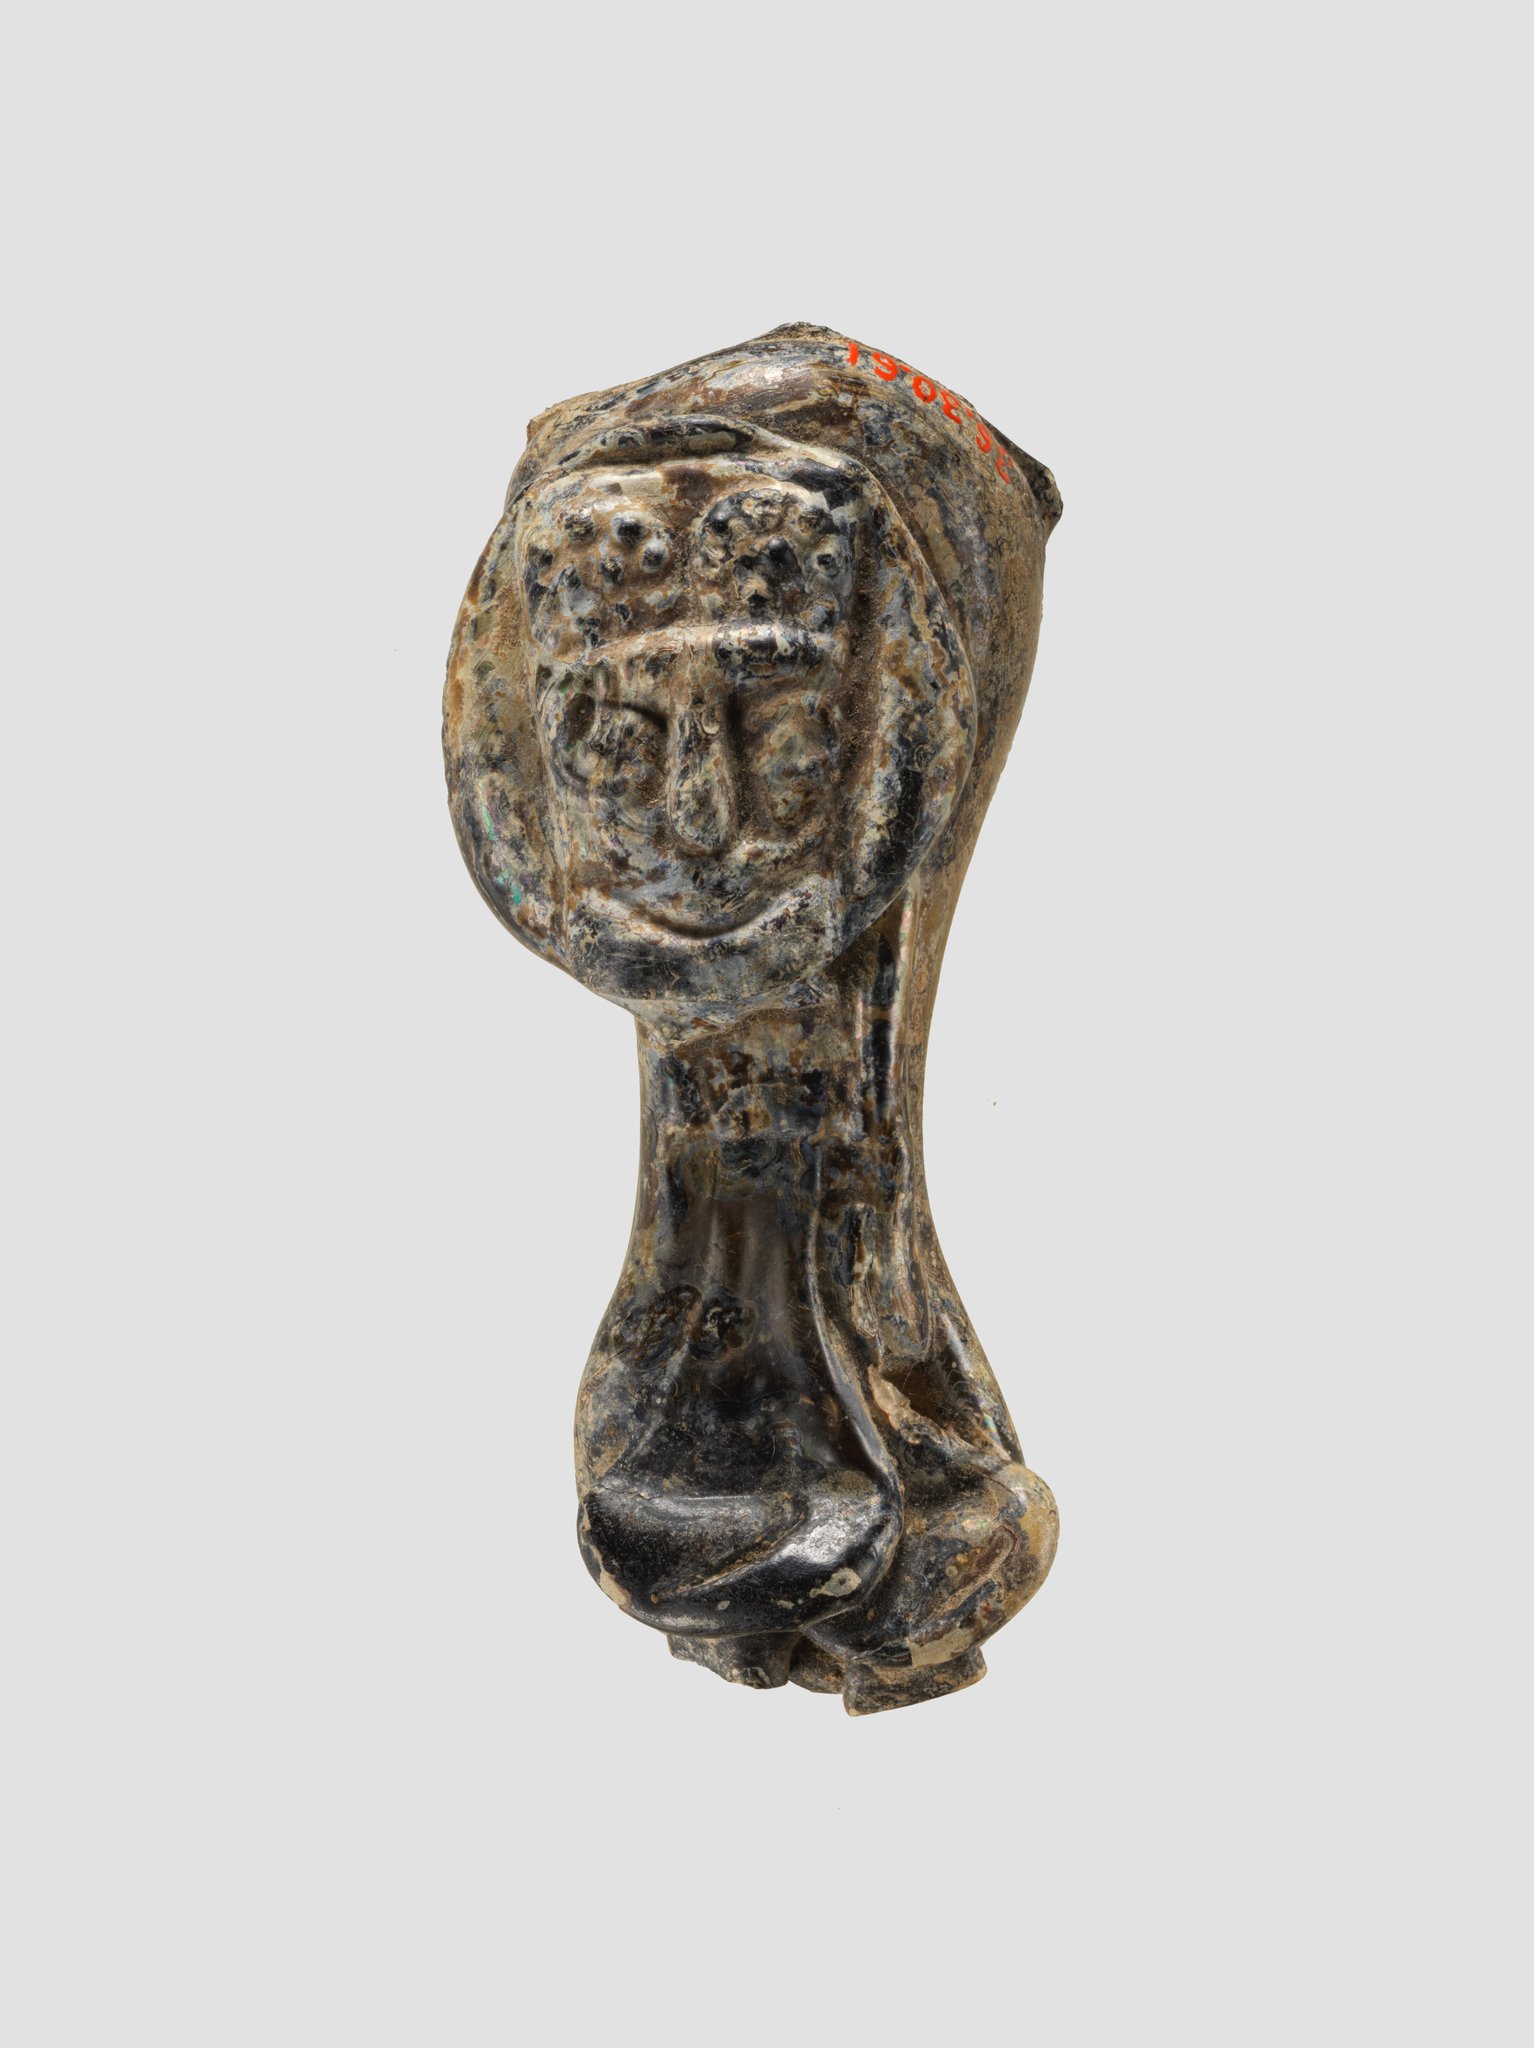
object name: handle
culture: sasanian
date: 201-700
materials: glass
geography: iran